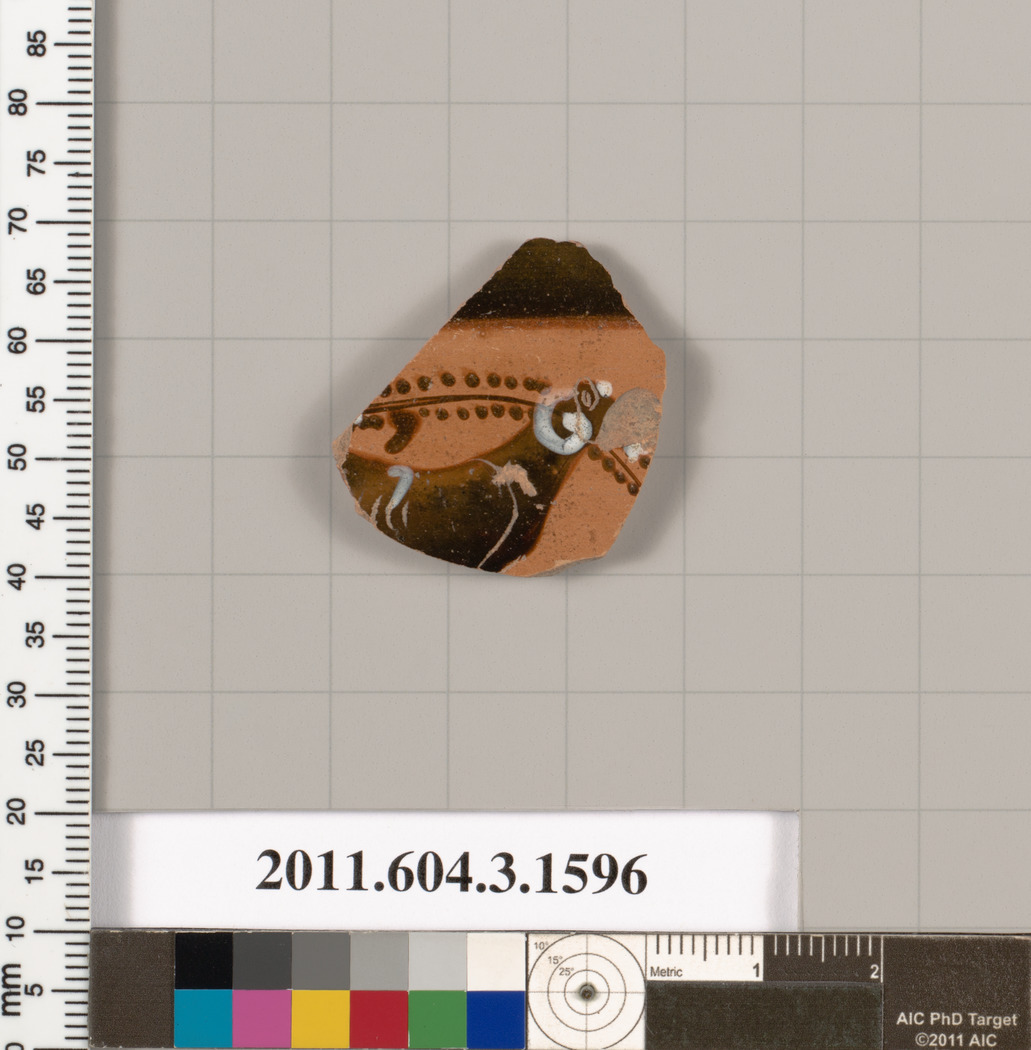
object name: kylix fragment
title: Terracotta fragment of a kylix: Band cup (drinking cup)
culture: greek, attic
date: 567-535 BCE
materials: terracotta